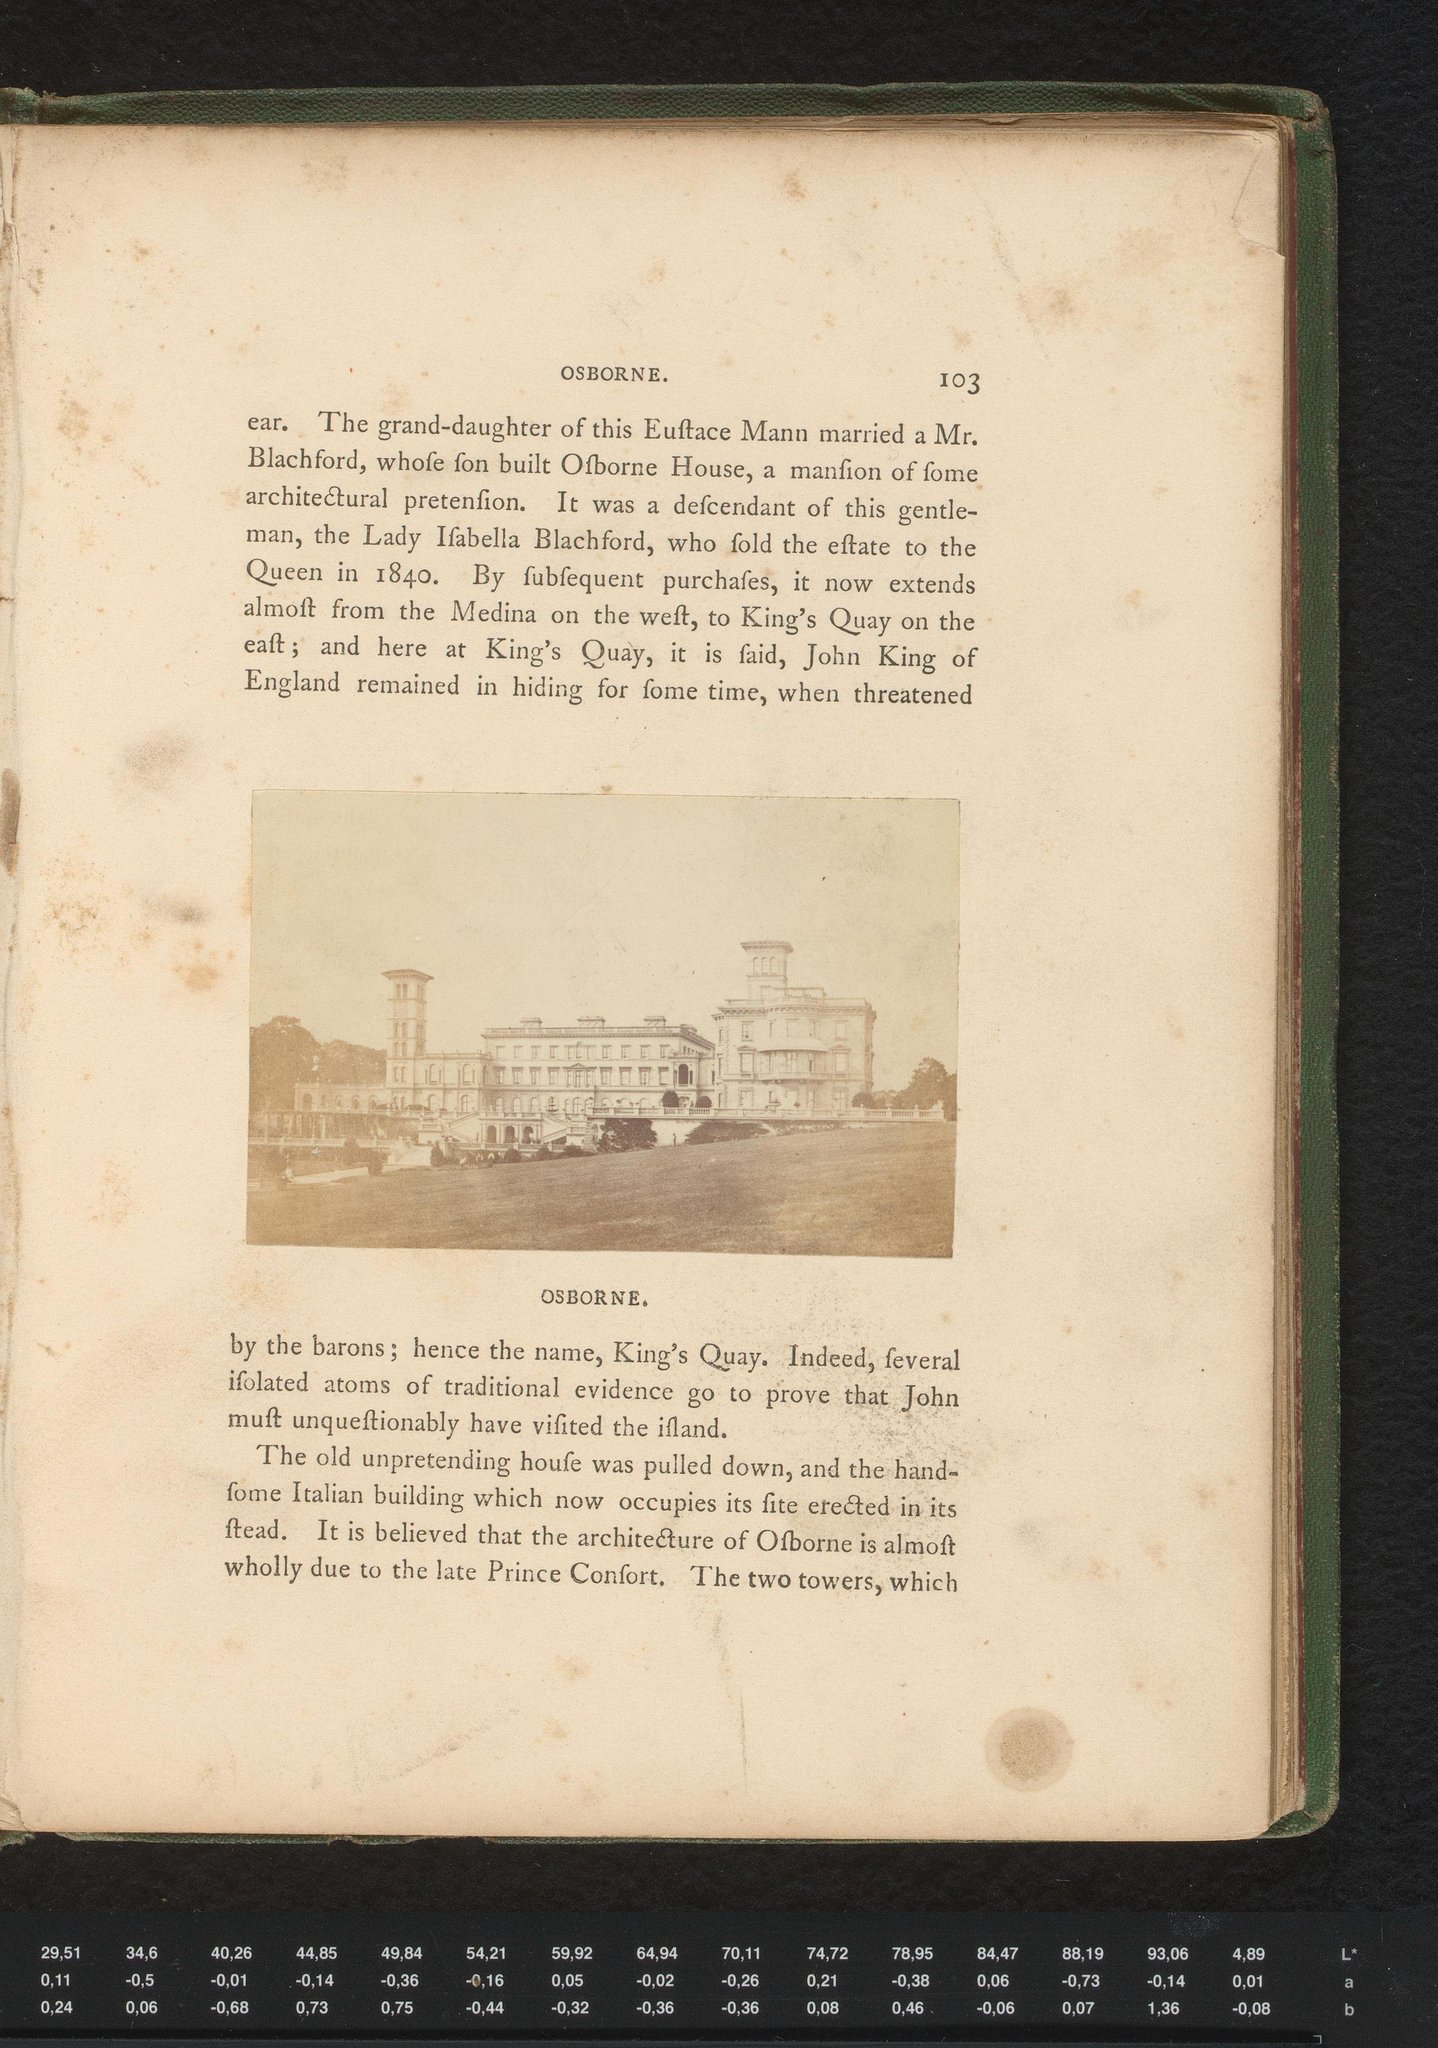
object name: page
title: Osborne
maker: william russell sedgfield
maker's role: fotograaf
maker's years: 1826-1902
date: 1864-1869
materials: paper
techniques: albumen print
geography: isle of wight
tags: rural housing, e.g. country-house, villa, cottage, façade (of house or building)